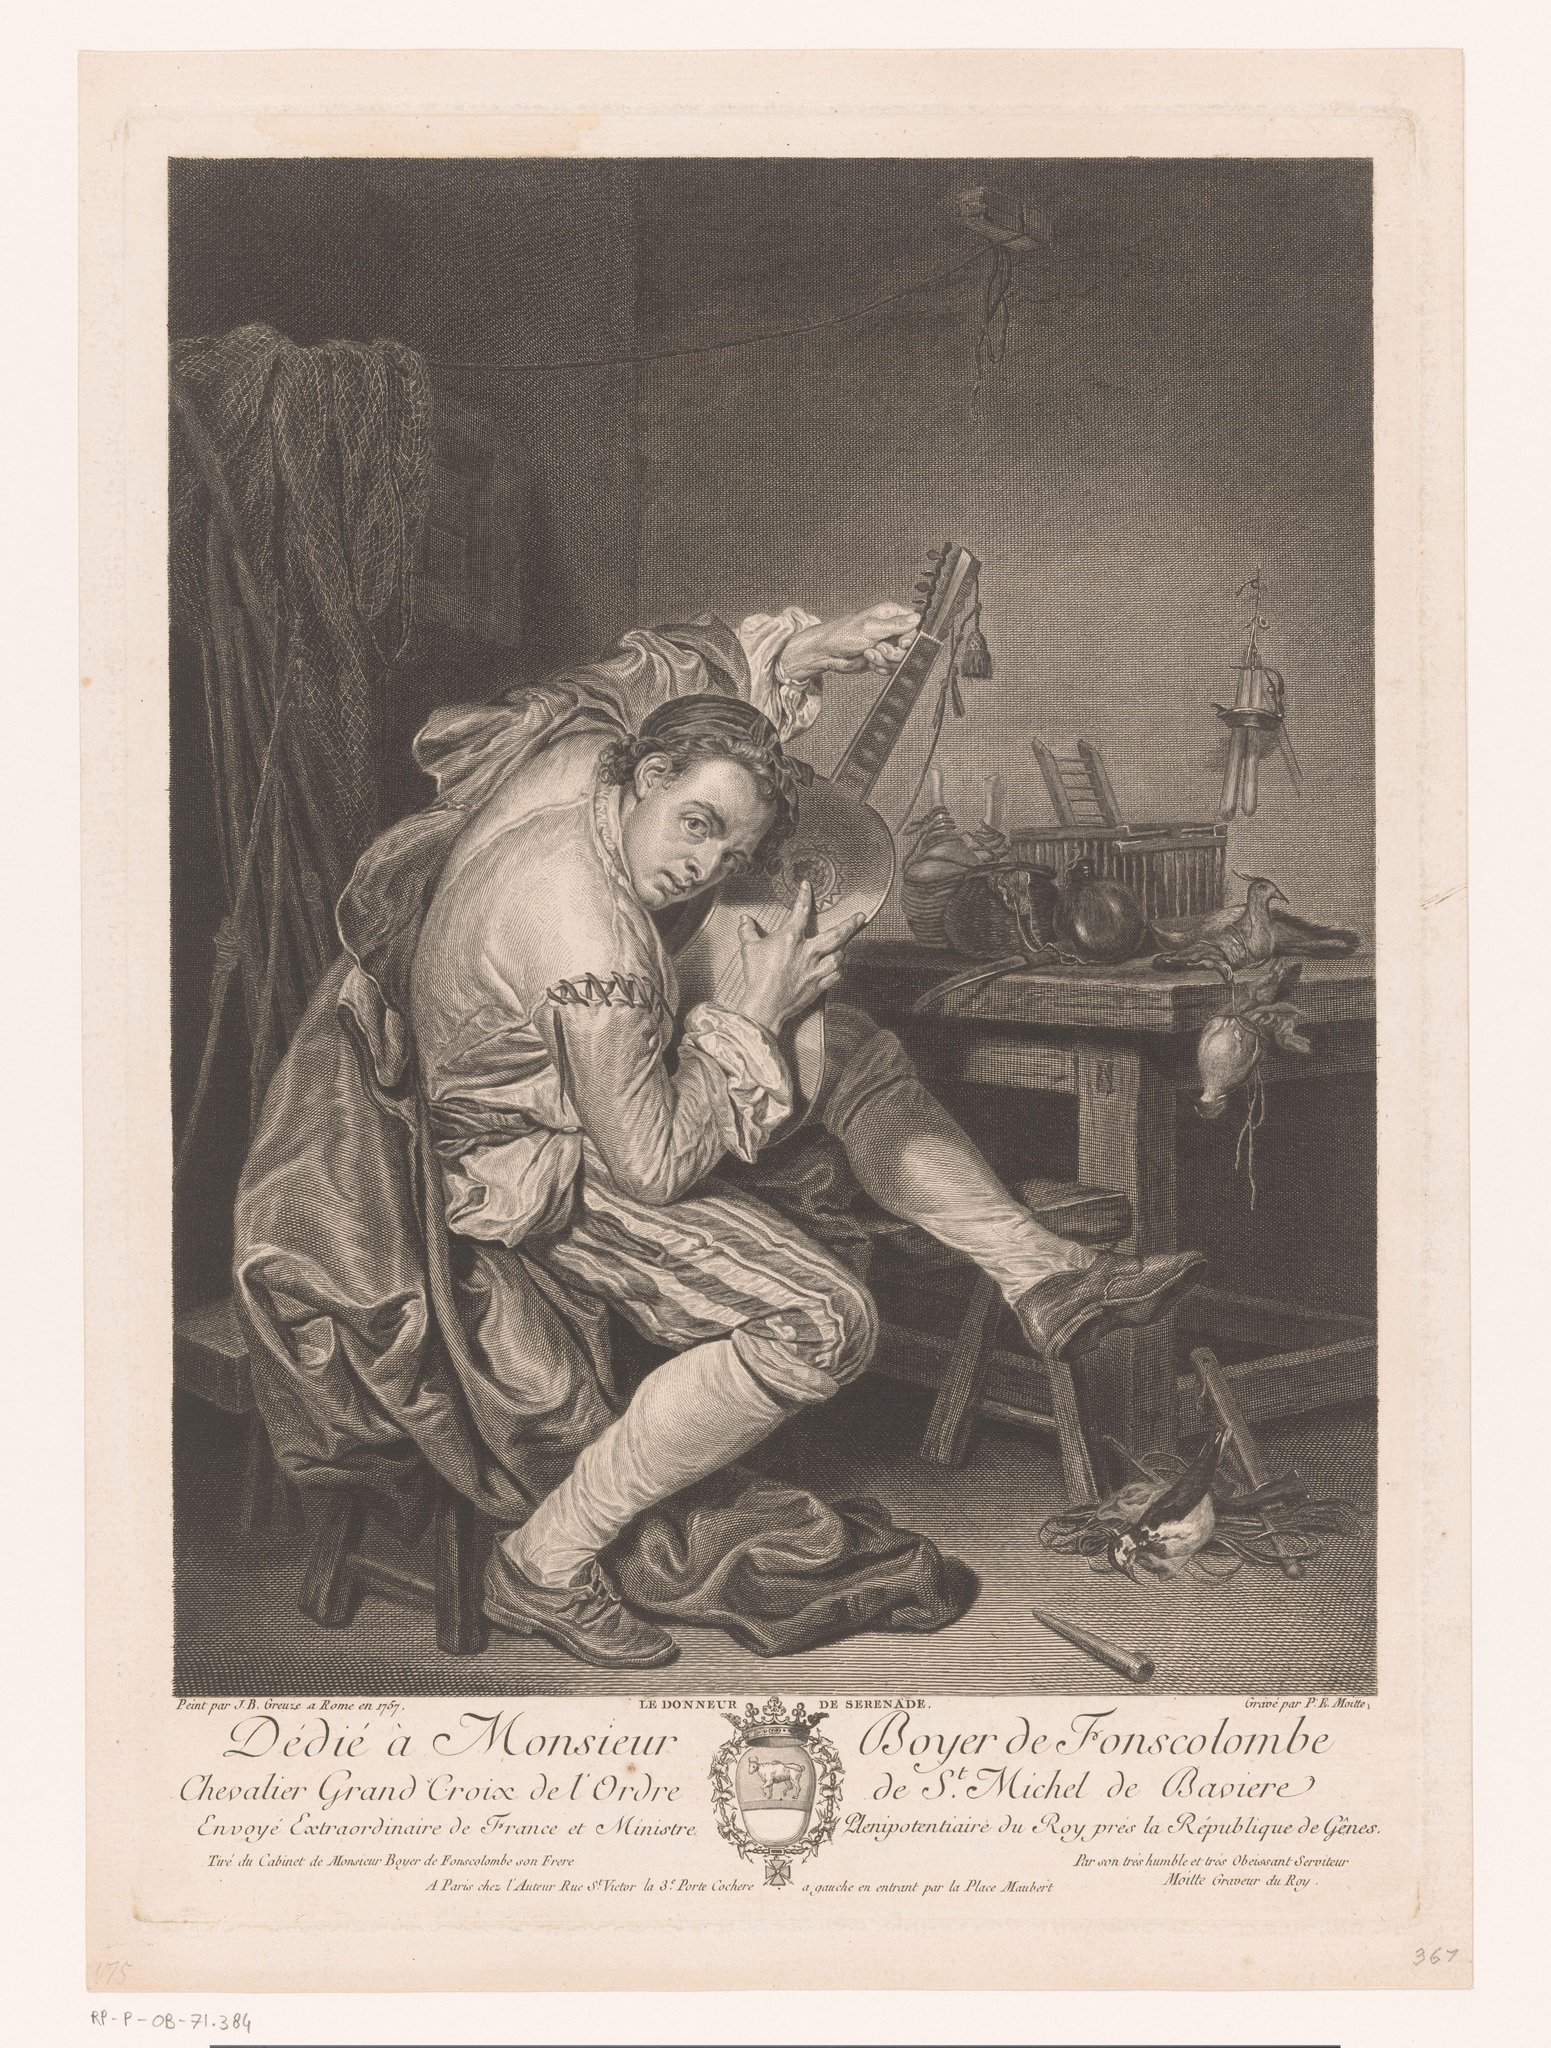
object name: print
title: Le Donneur de Serenade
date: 1757-1780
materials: paper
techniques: engraving, etching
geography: paris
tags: musician, tuning an instrument, cithern, mandolin, guitar, balalaika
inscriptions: collector's mark: Lugt 2228